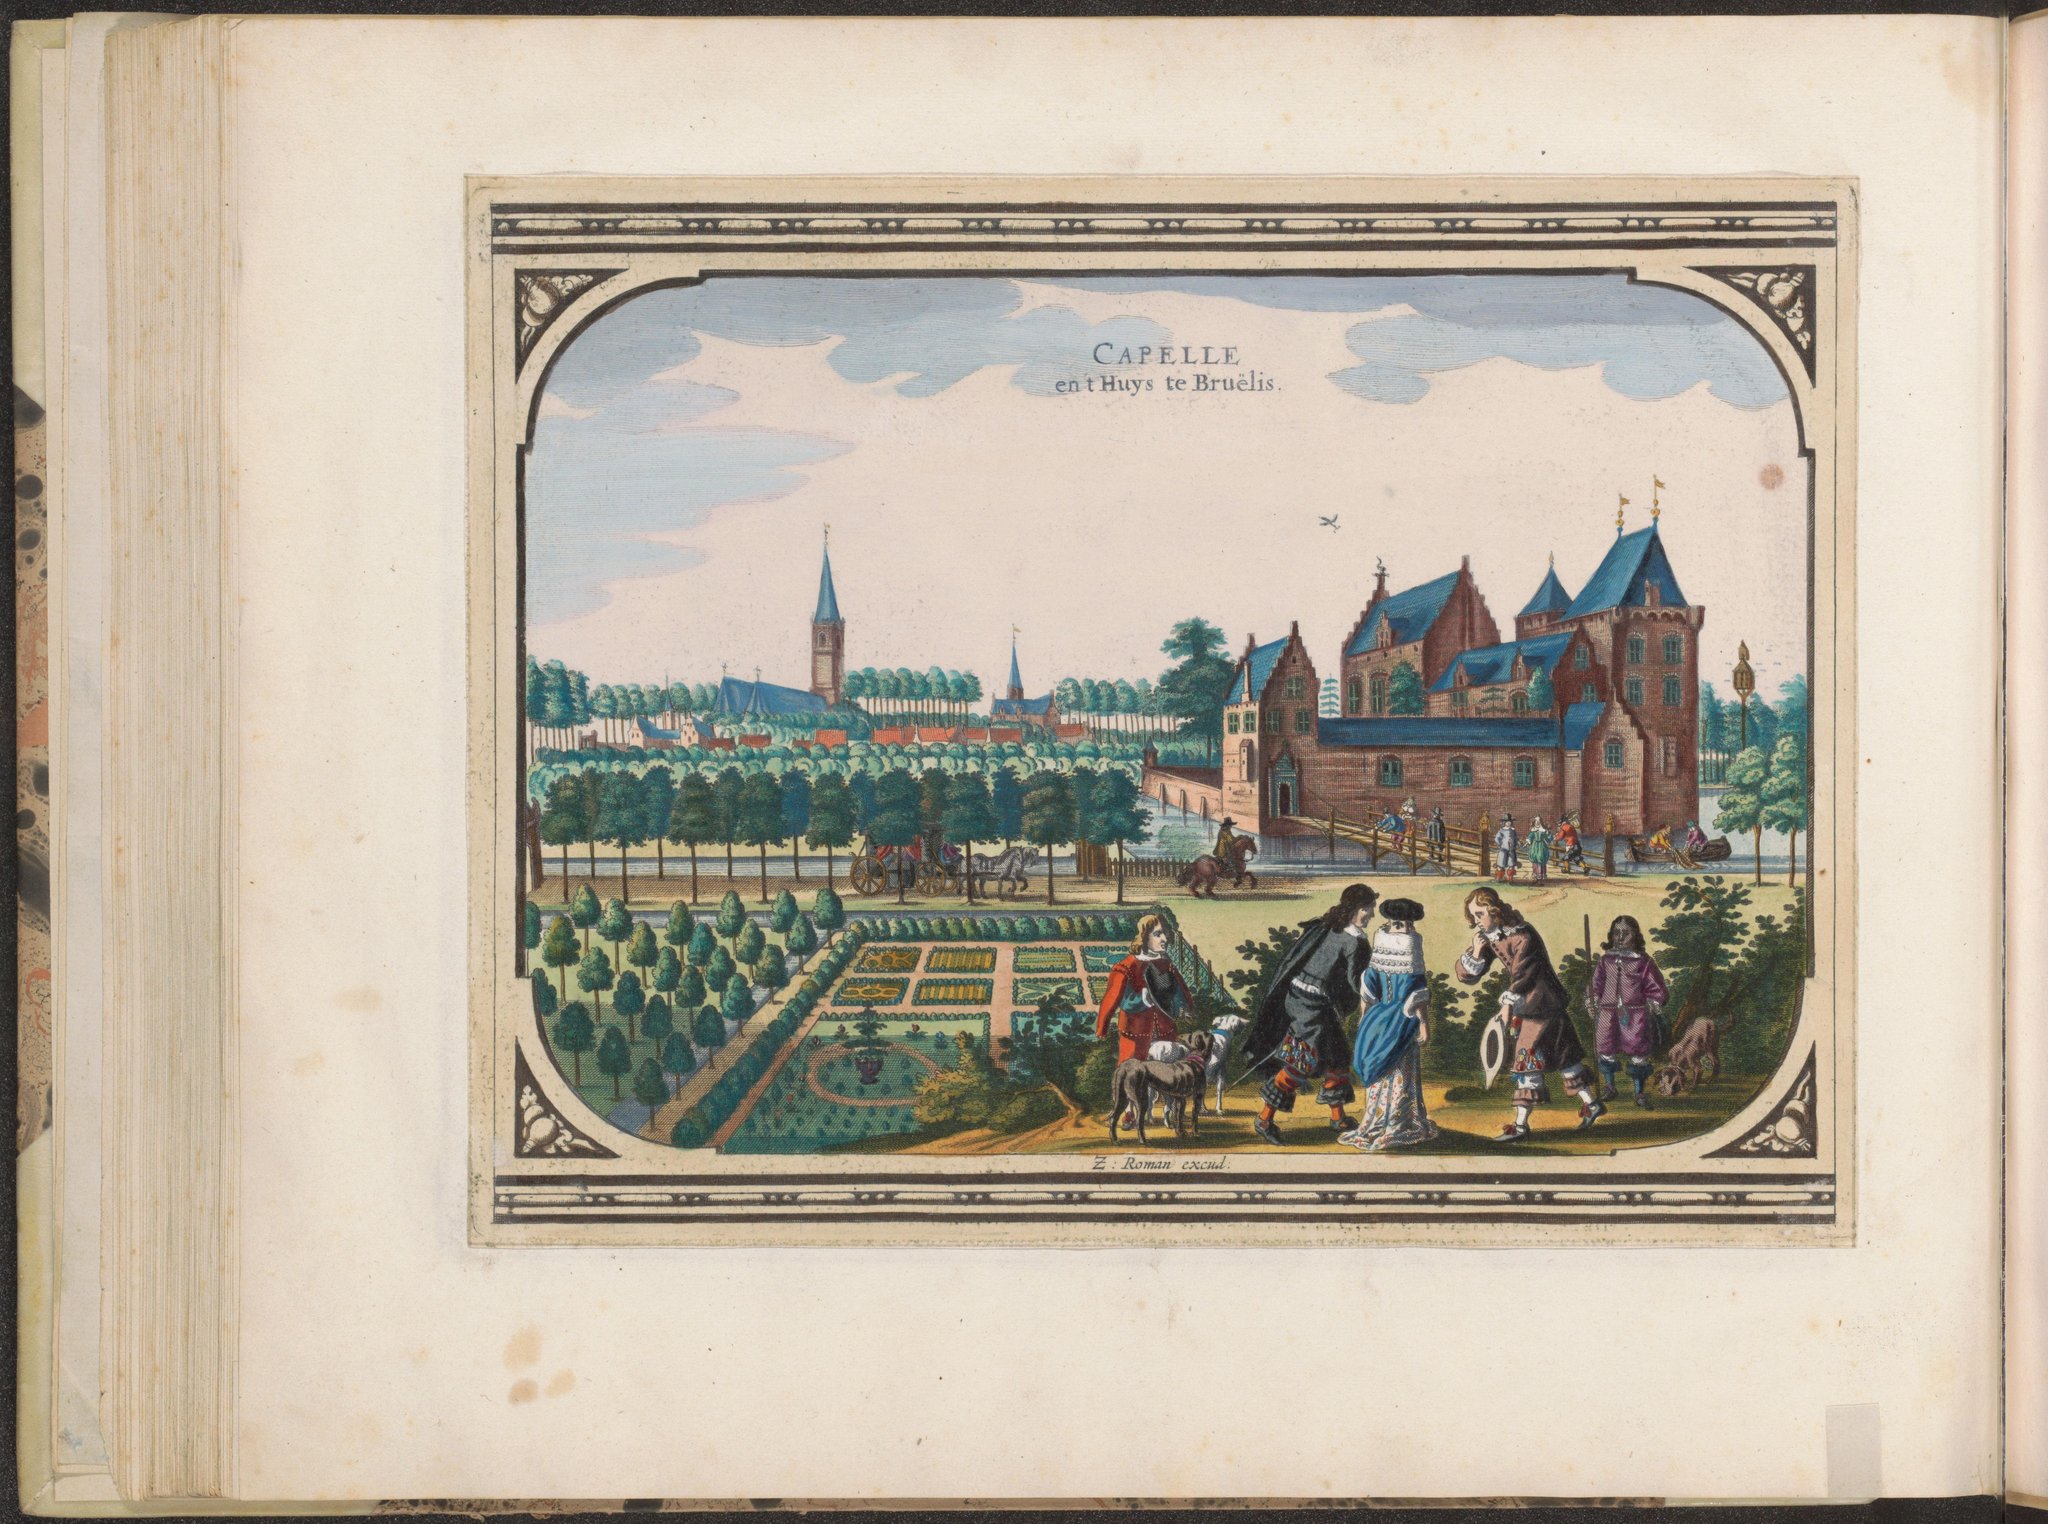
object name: album leaf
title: Gezicht op kasteel Bruëlis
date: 1662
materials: paper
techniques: etching, hand coloring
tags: city-view, and landscape with man-made constructions, castle, baring the head, lifting one's hat, the rich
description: Gezicht op Kapelle en het kasteel Bruëlis. Op de voorgrond zet een heer zijn hoed af voor een welgesteld wandelend paar. De prent maakt deel uit van een album.